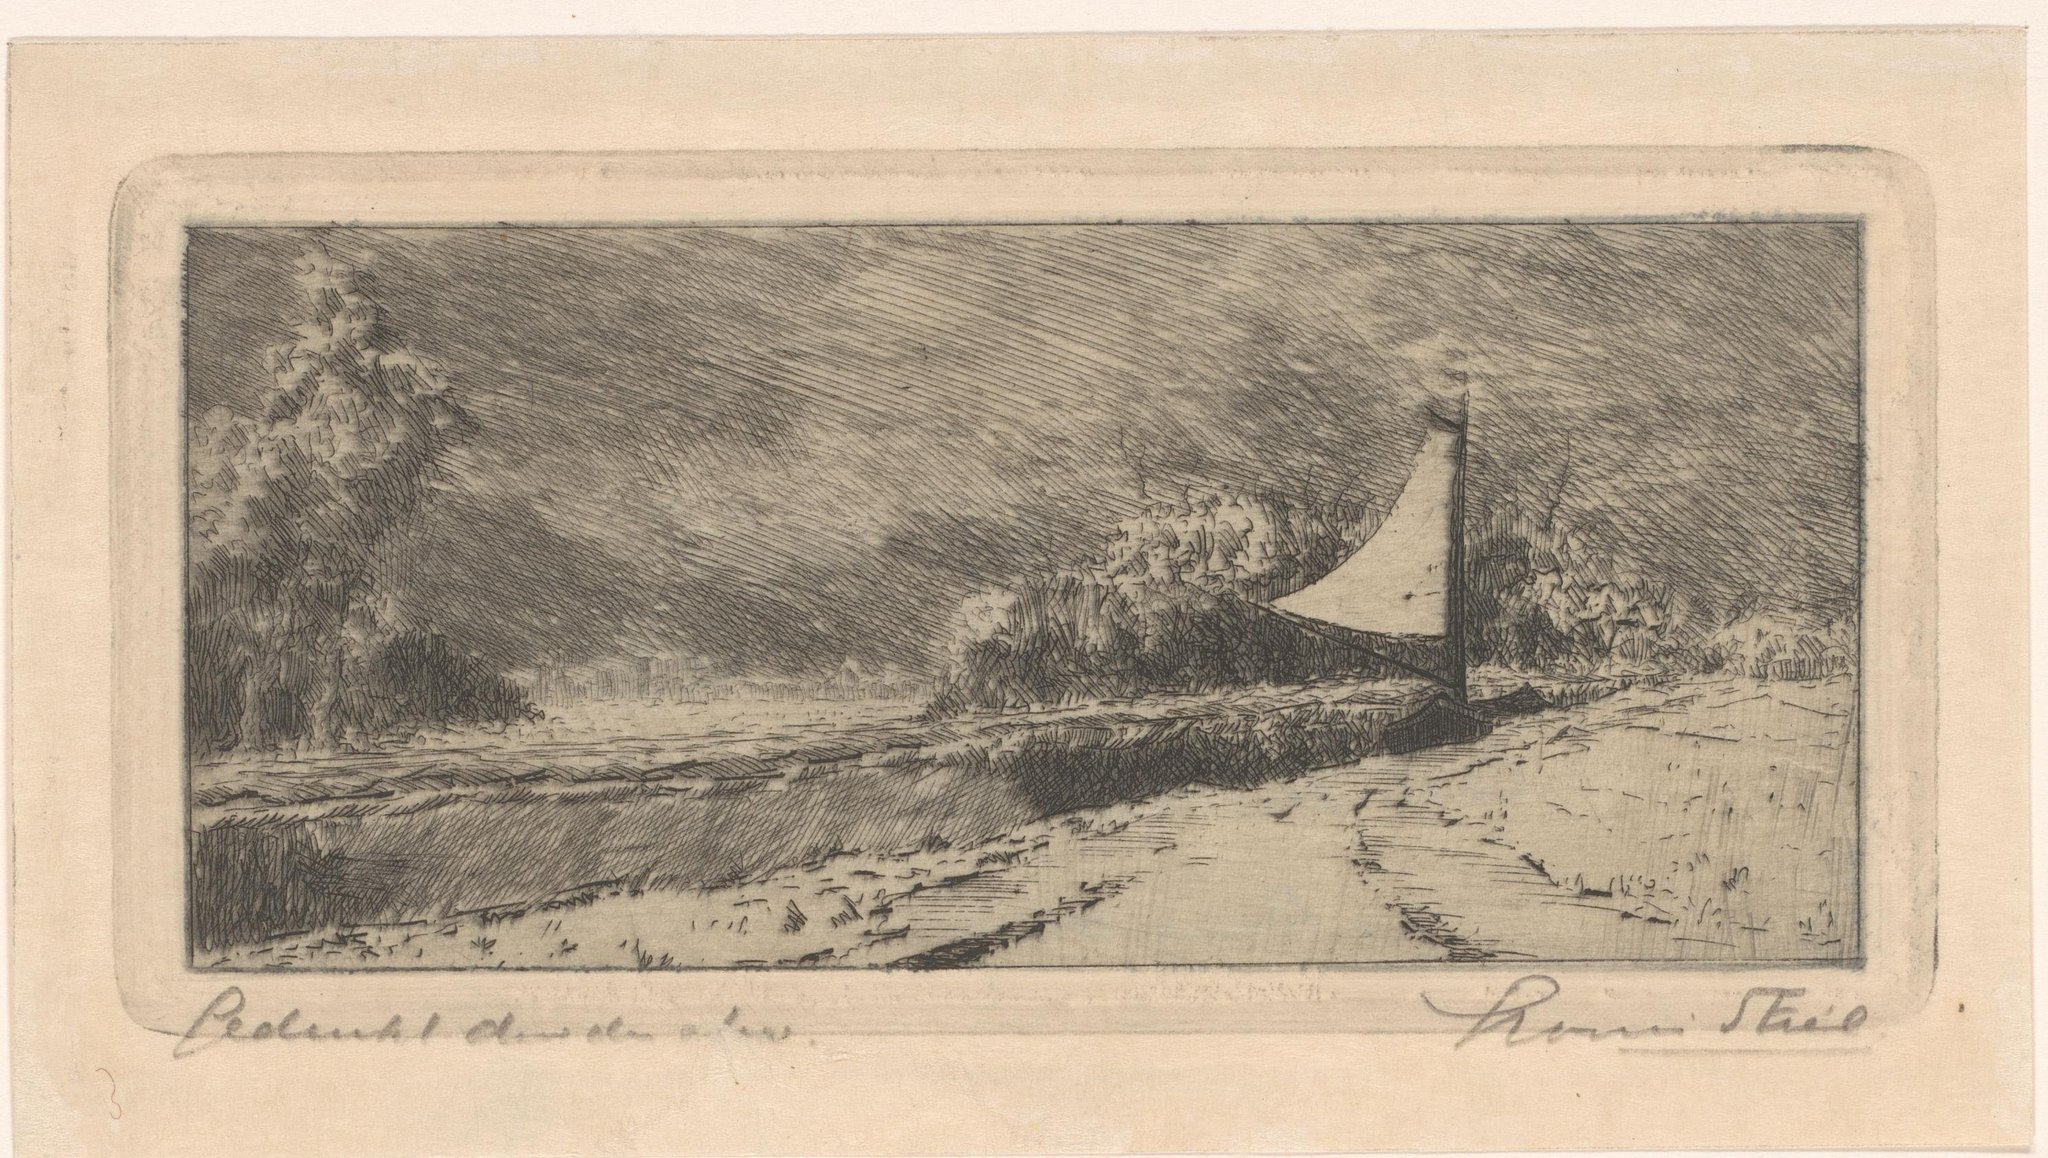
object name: print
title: Landschap met vaart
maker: louis stiel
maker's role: print maker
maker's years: 1881-1950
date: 1891-1937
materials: paper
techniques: etching, intaglio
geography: netherlands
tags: canal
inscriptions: collector's mark: Lugt 2760, collector's mark: Lugt 2228